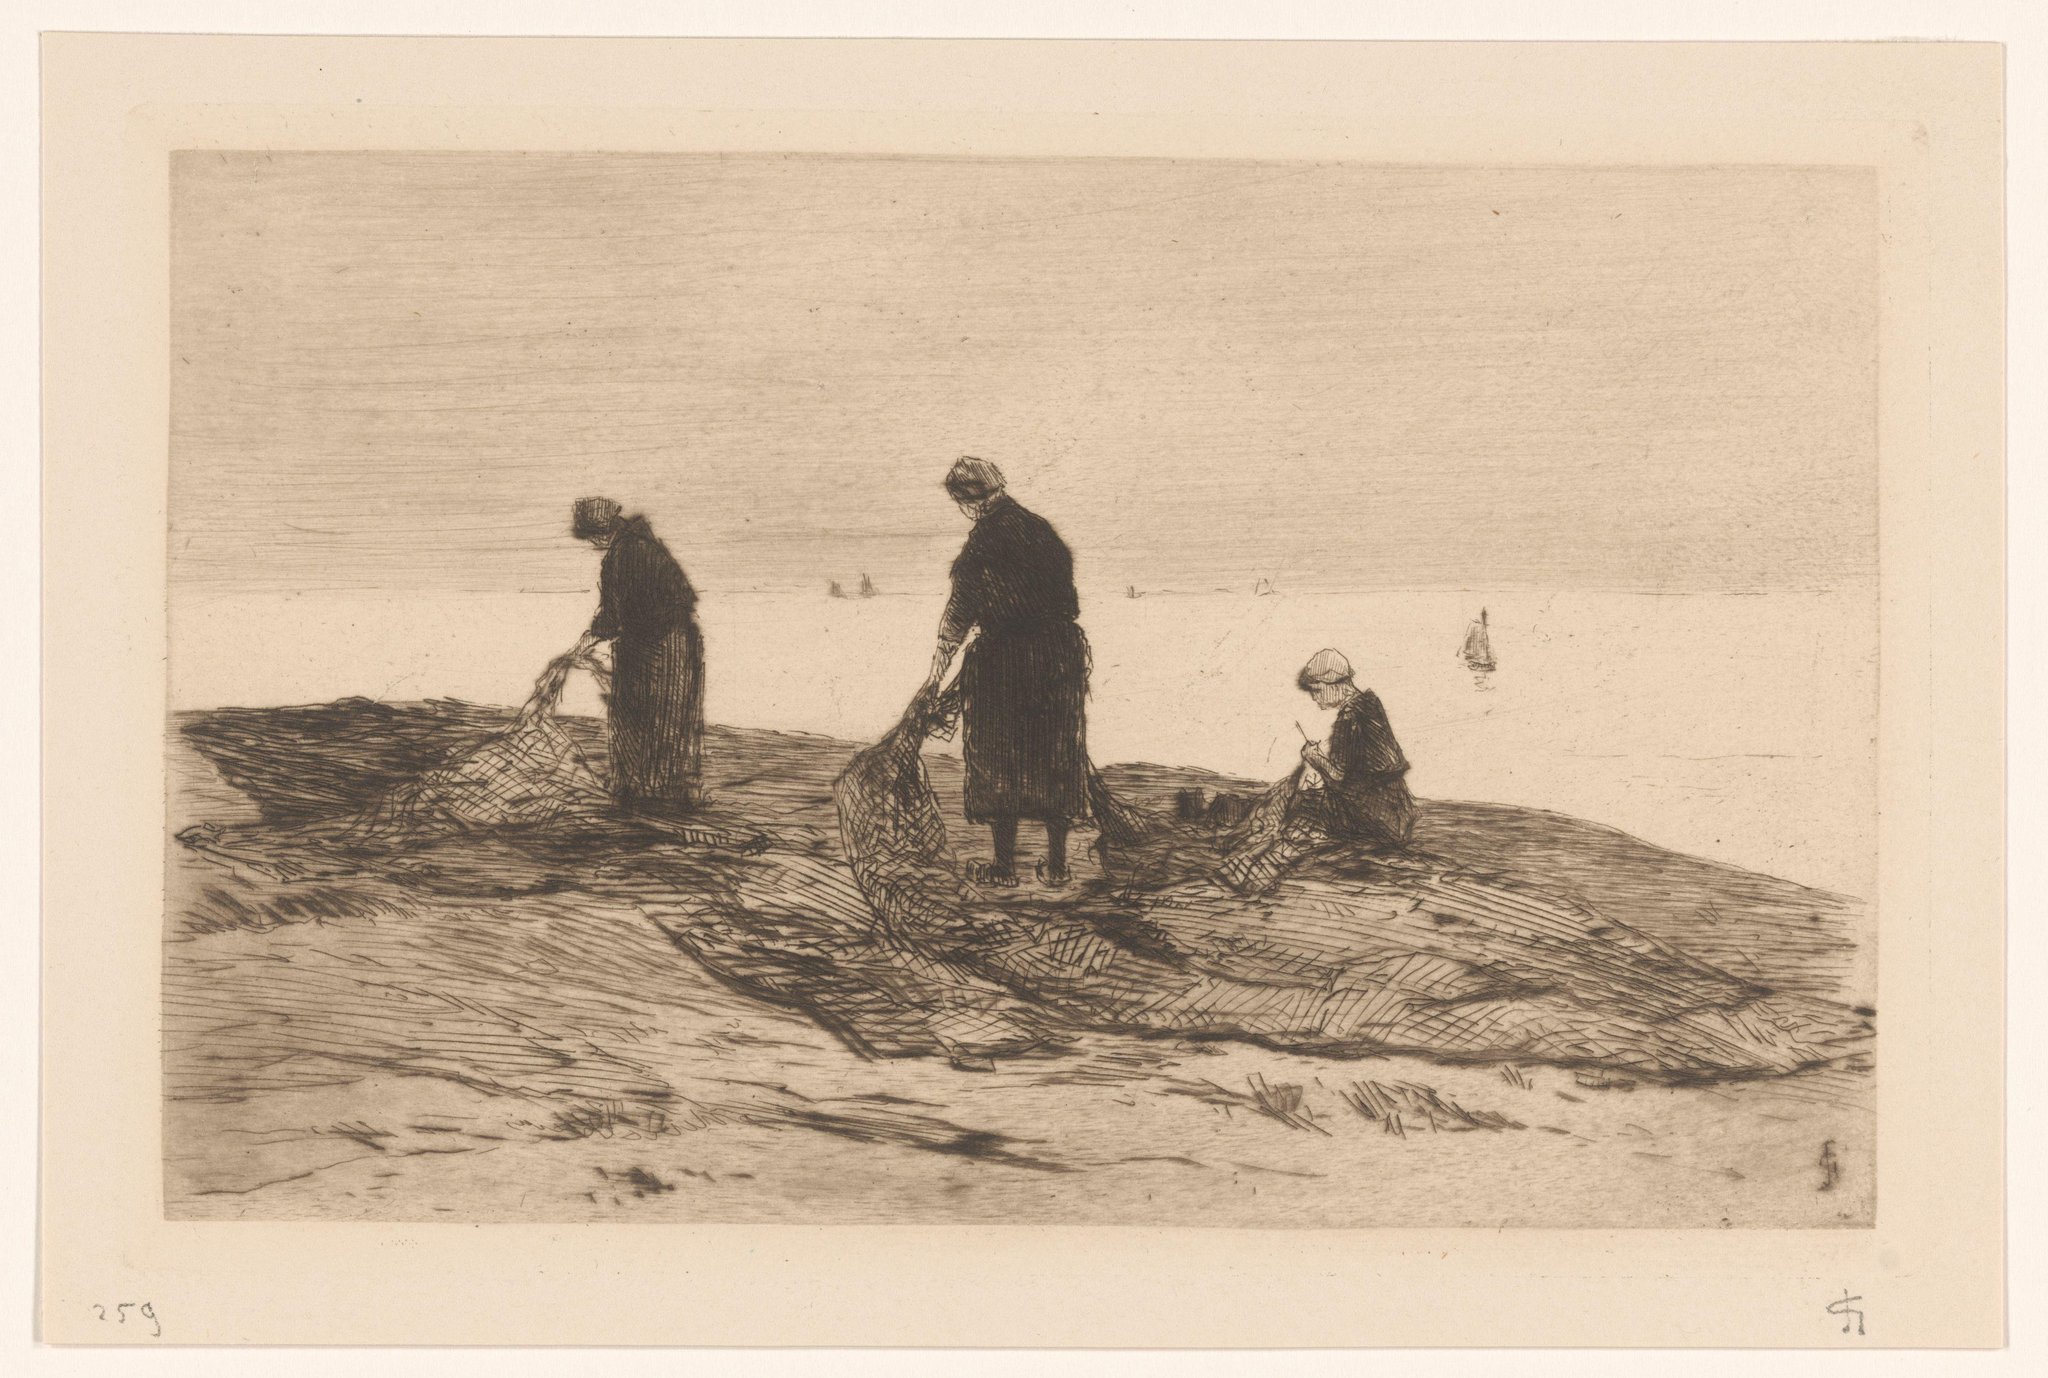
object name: print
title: Nettenboetsters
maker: carel nicolaas storm van s-gravesande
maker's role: draughtsman, print maker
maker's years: 1841-1924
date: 1887-1889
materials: paper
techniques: drypoint, etching, intaglio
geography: netherlands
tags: mending of fishing nets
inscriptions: collector's mark: Lugt 2228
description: Drie vrouwen repareren visnetten aan de kust.